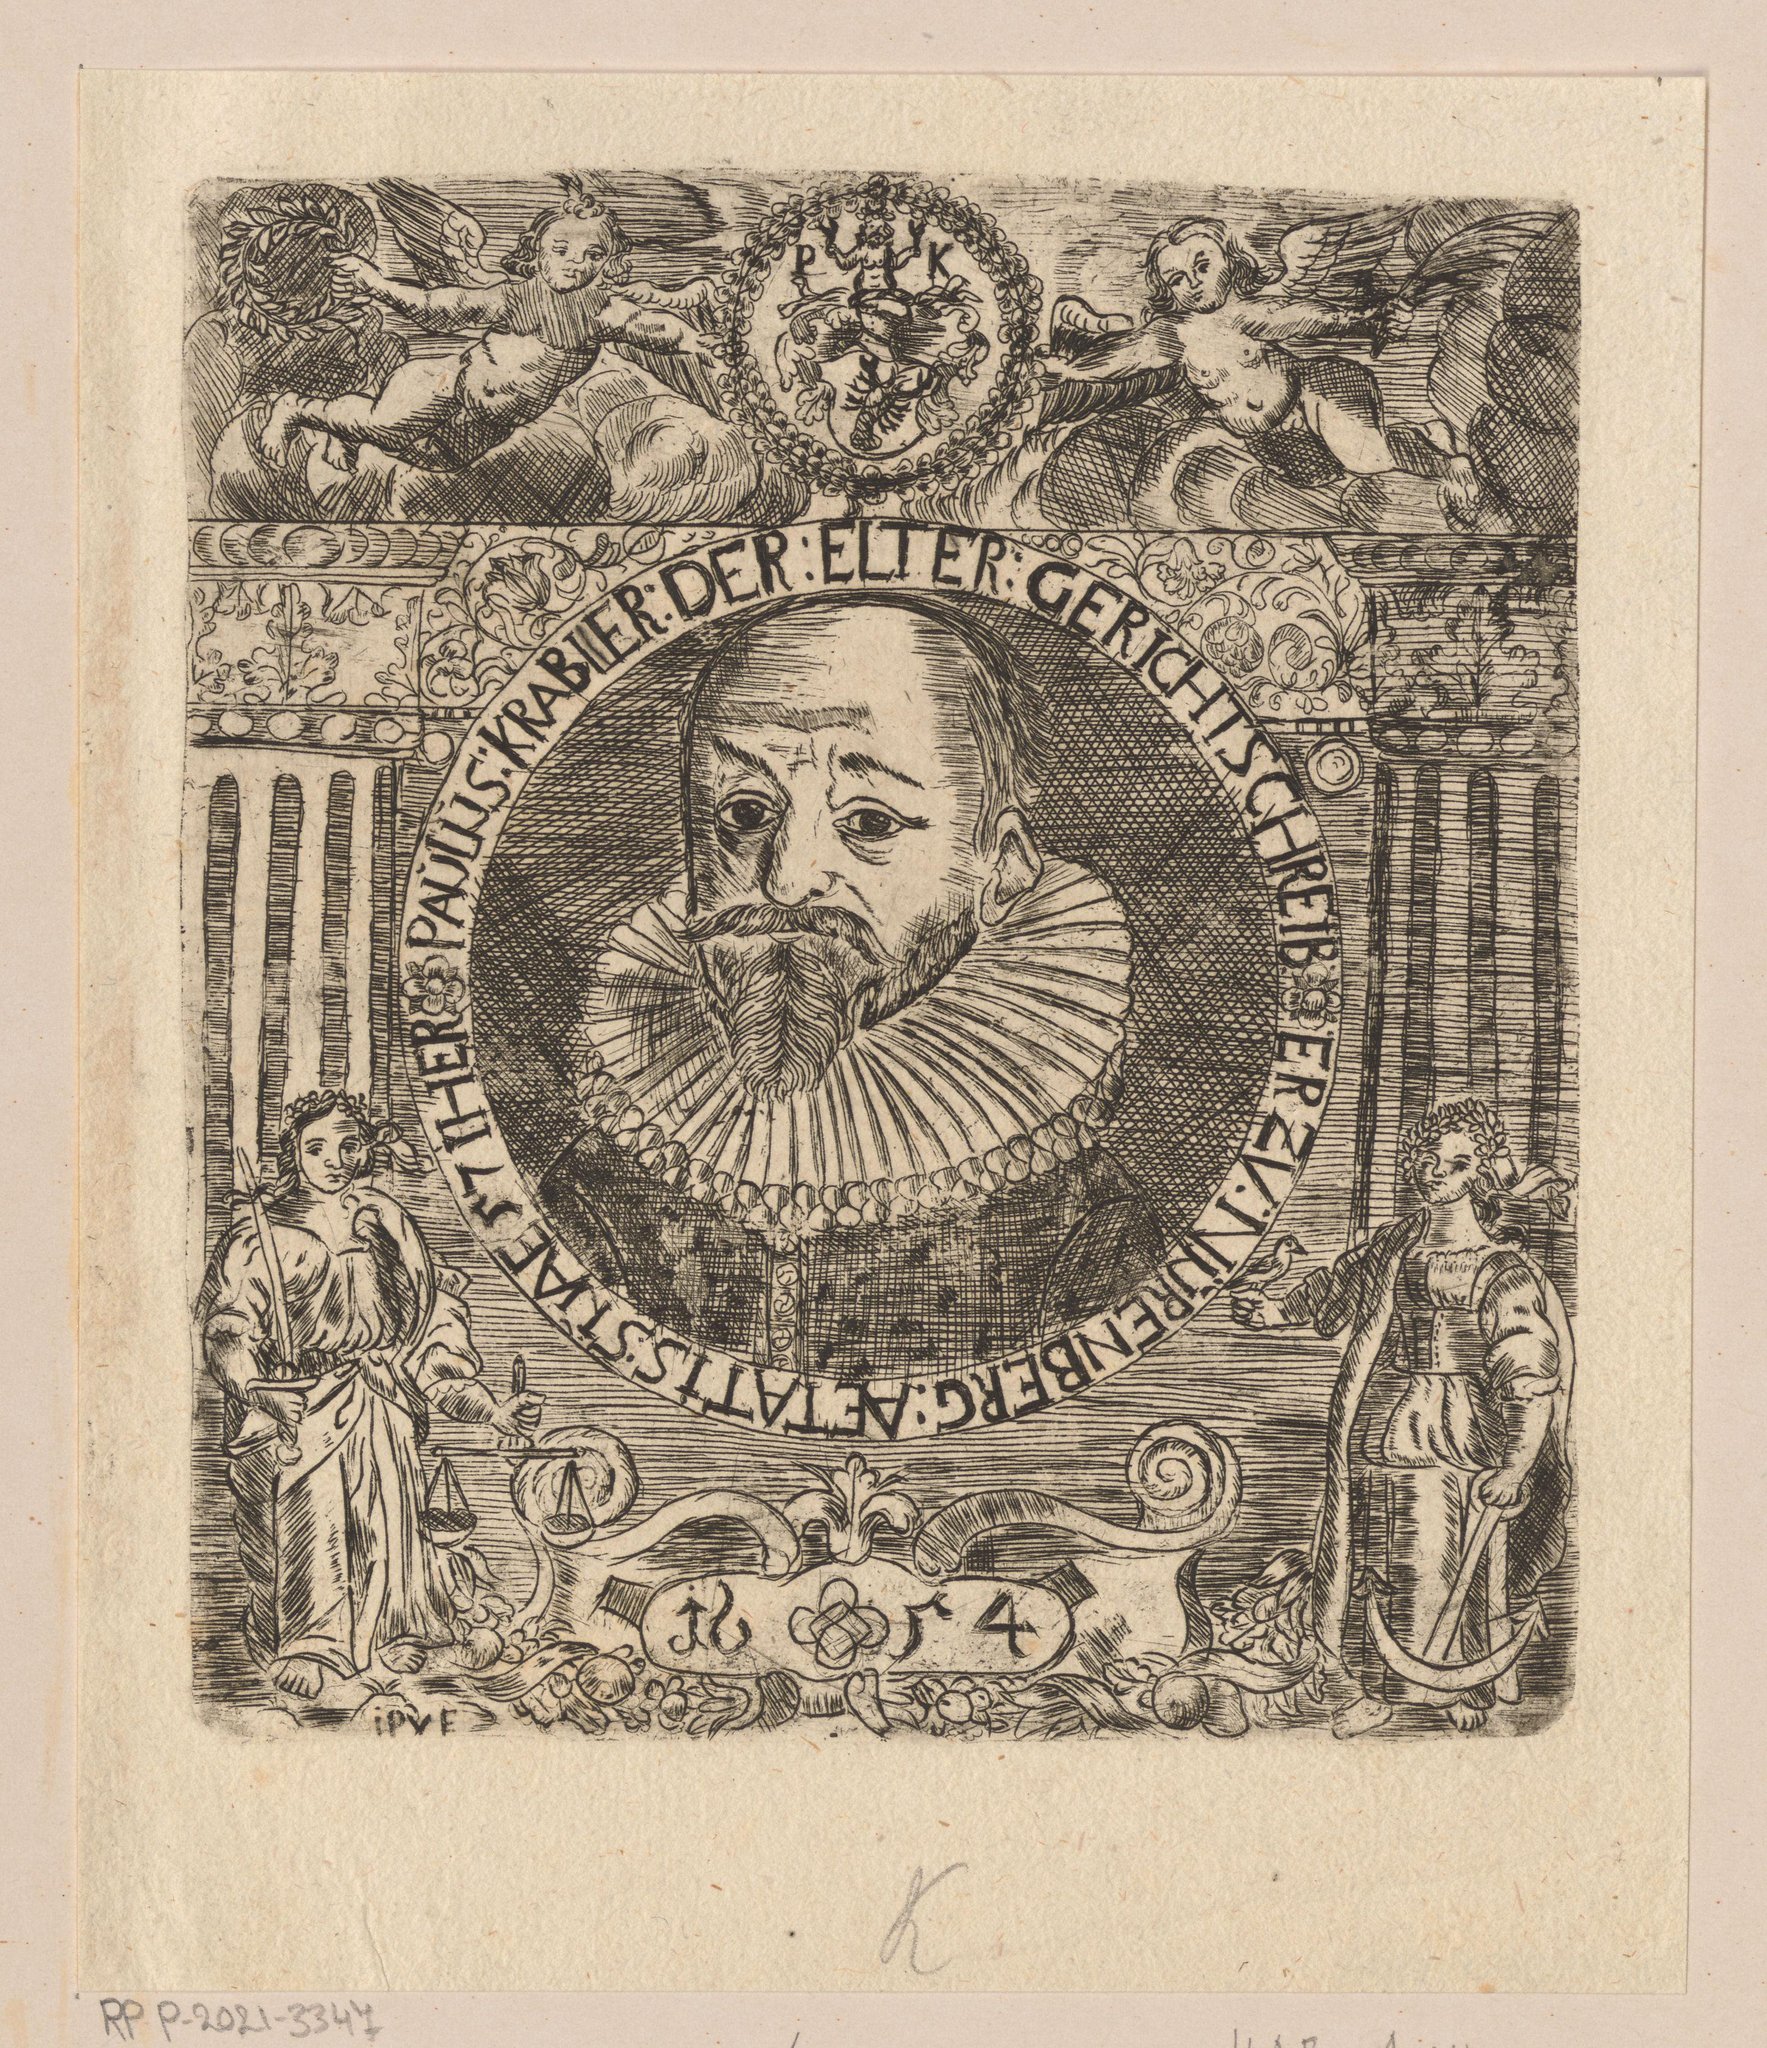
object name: print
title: Portret van Paul Krabler I op 57-jarige leeftijd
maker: johann paul von eyb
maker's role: handwerksman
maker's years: 1627-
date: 1654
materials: paper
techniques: engraving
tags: justice, 'justitia'; 'giustitia divina' (ripa) ~ one of the four cardinal virtues, hope, 'spes'; 'speranza divina e certa' (ripa) ~ one of the three theological virtues, historical persons, armorial bearing, heraldry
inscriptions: date